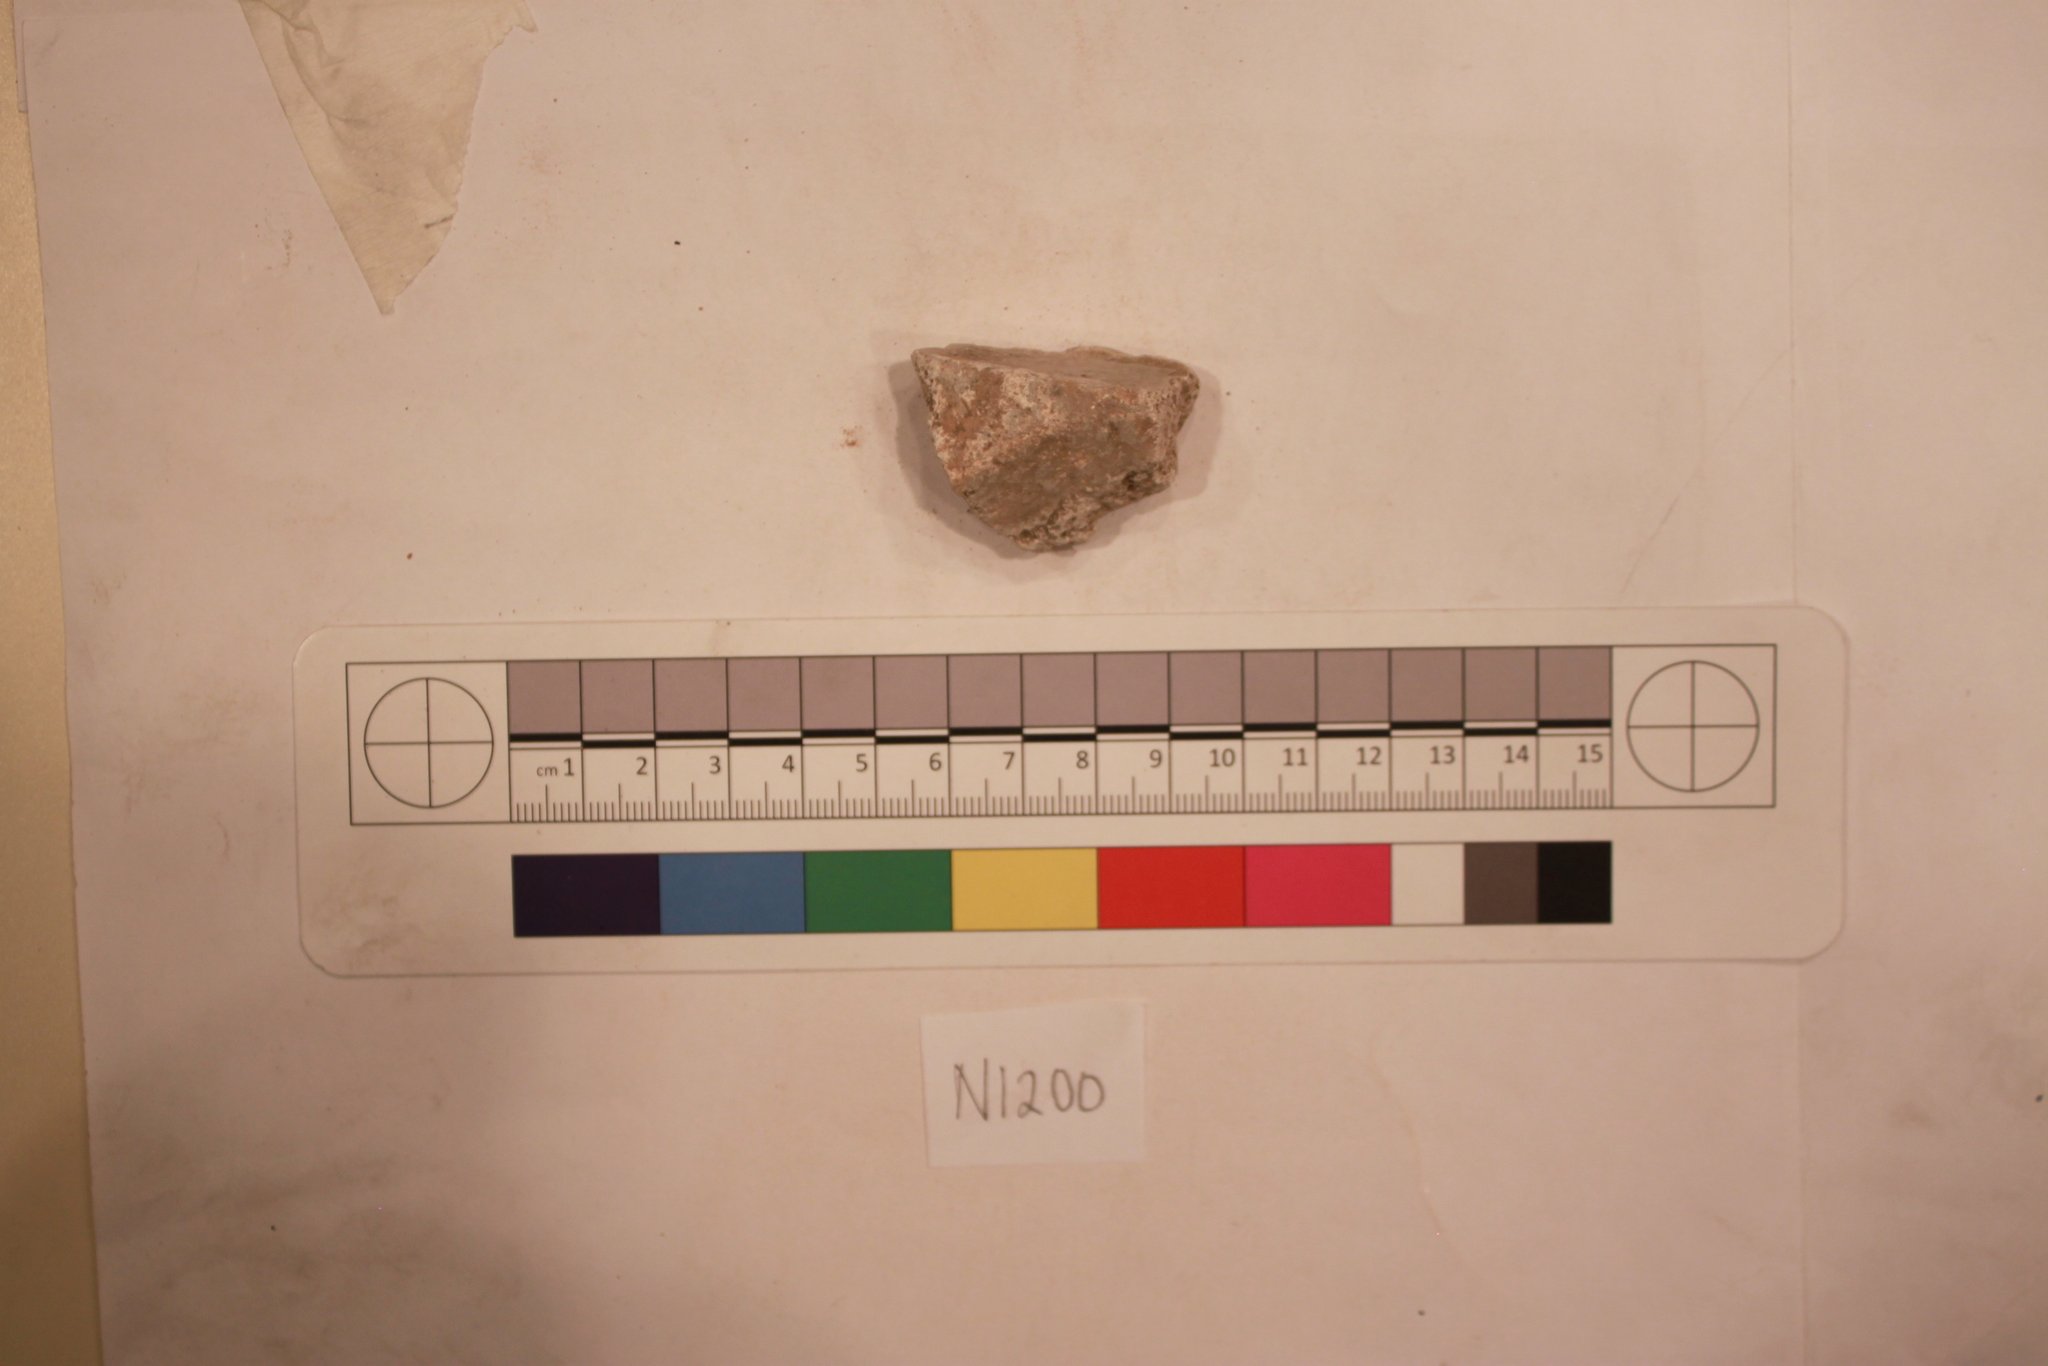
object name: fragment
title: Stucco Fragment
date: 701-1200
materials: plaster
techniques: carving, painting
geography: iran